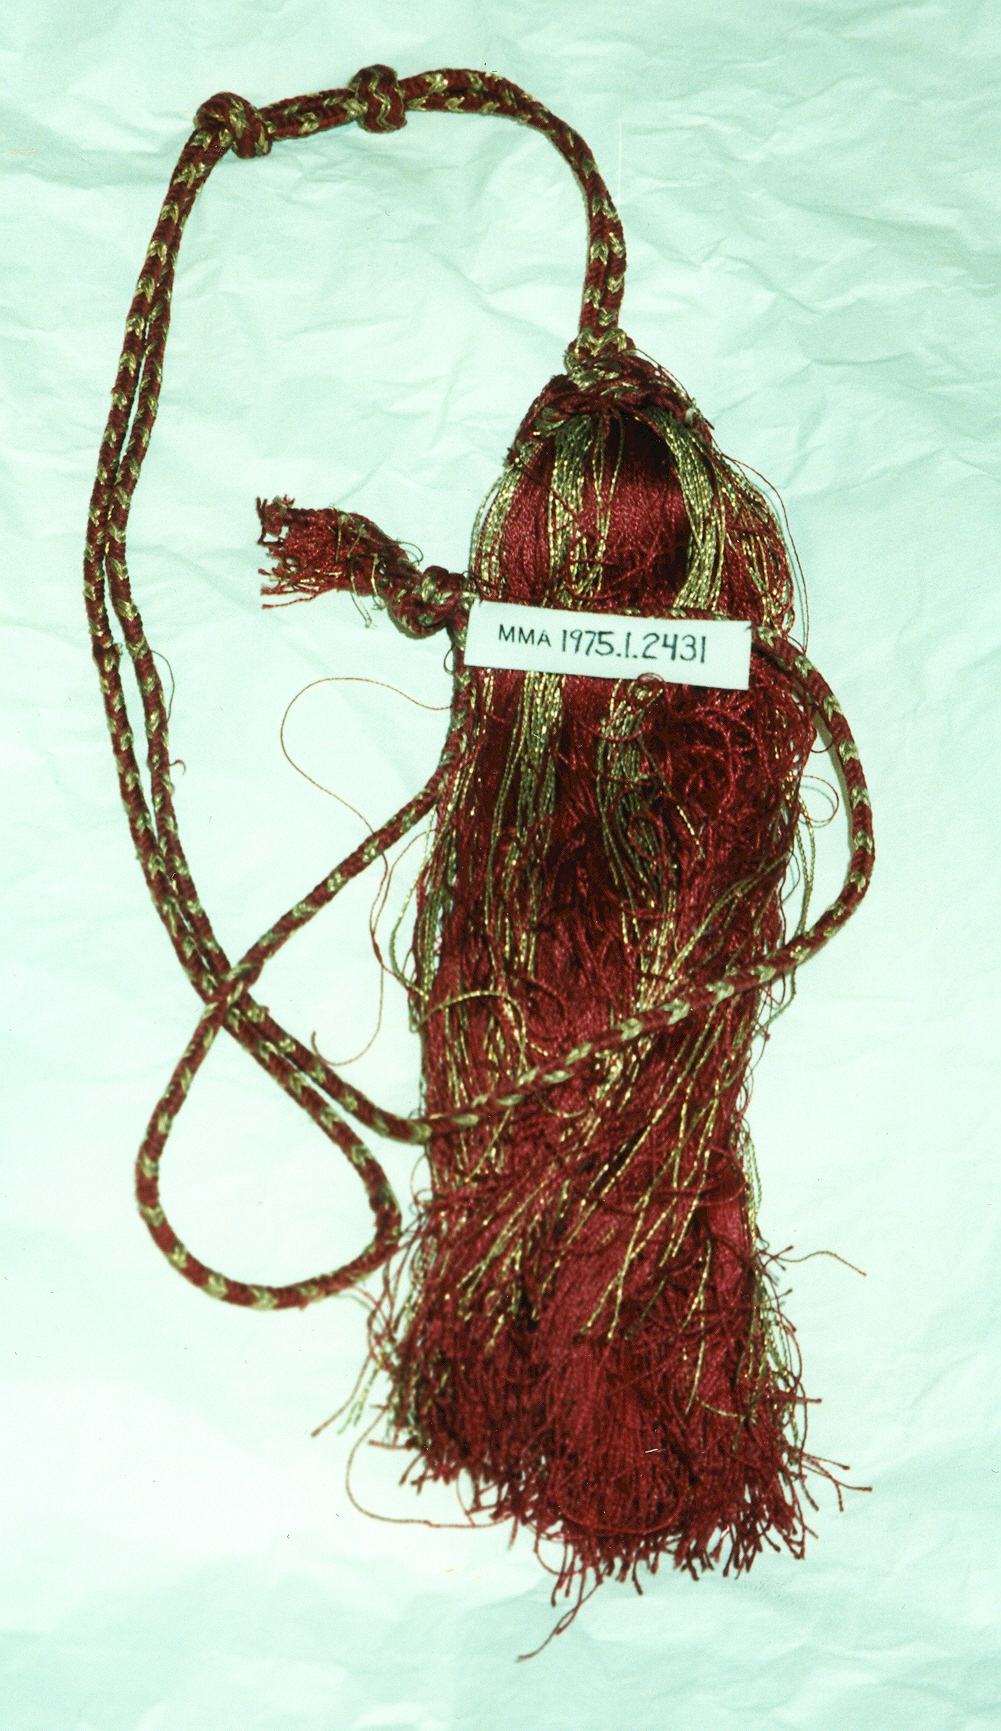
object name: tassel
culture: european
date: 1601-1900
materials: metal, silk